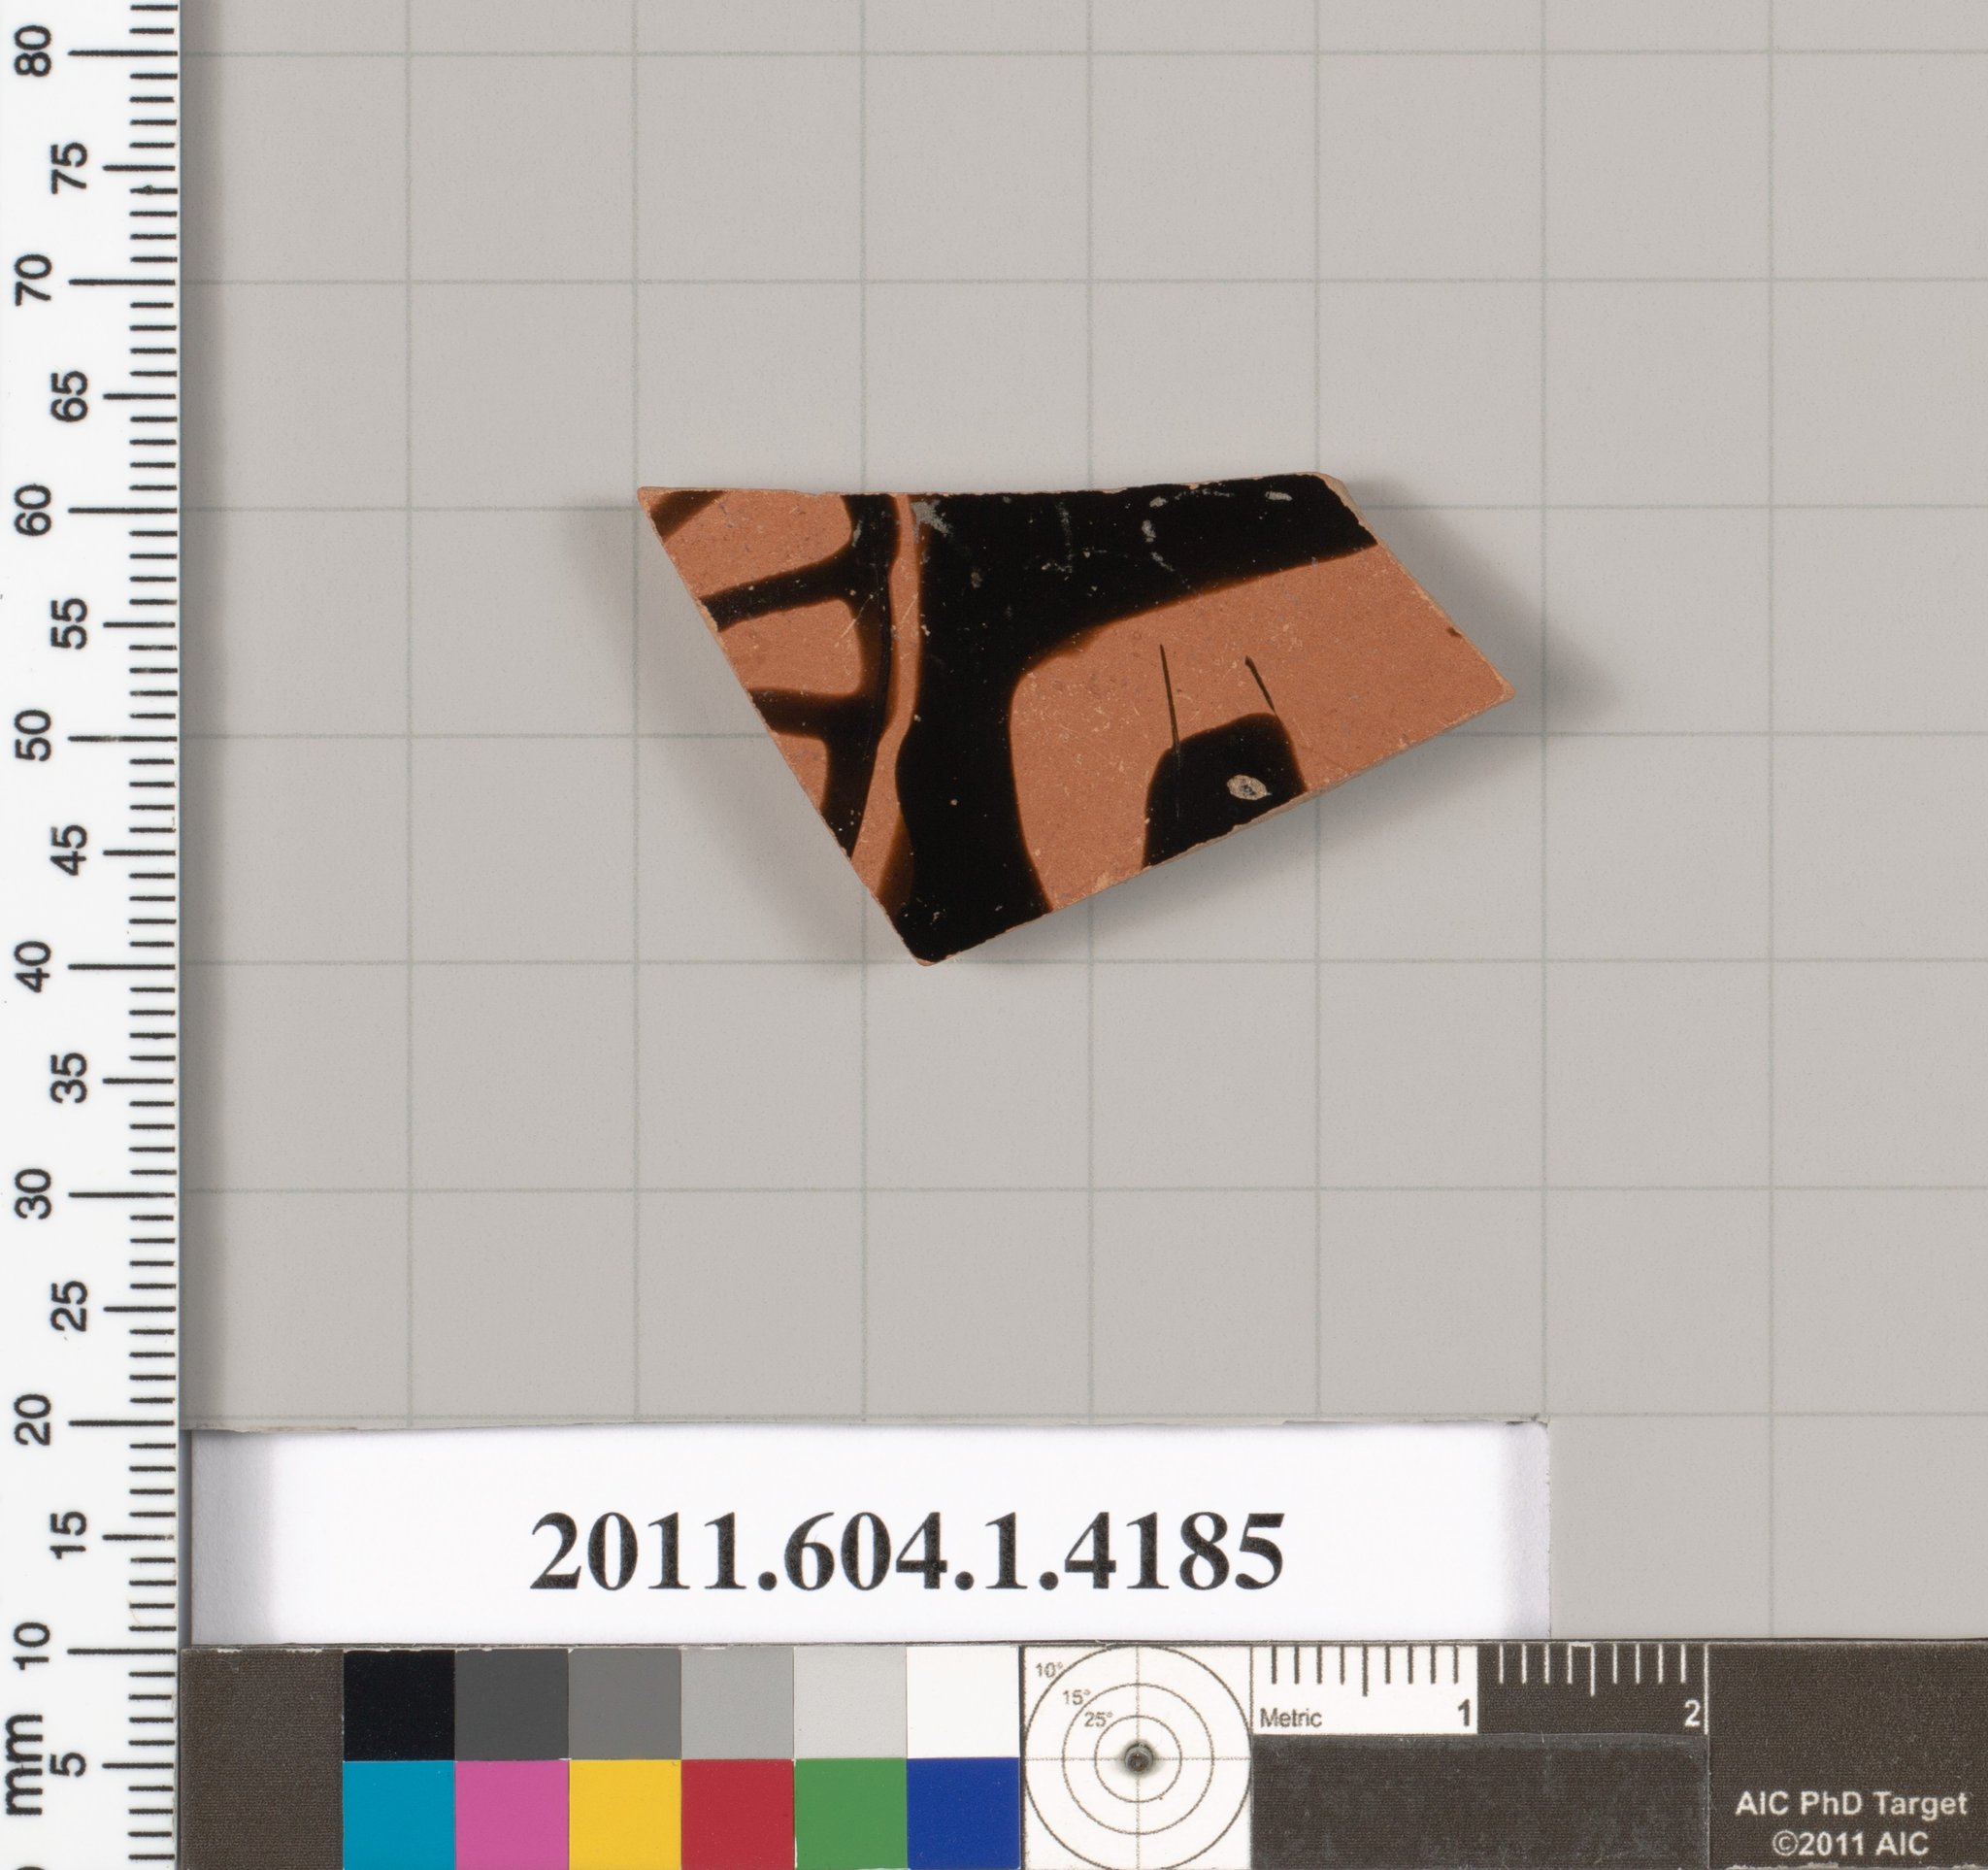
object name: kylix fragment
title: Terracotta fragment of a kylix (drinking cup)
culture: greek, attic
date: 467-435 BCE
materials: terracotta